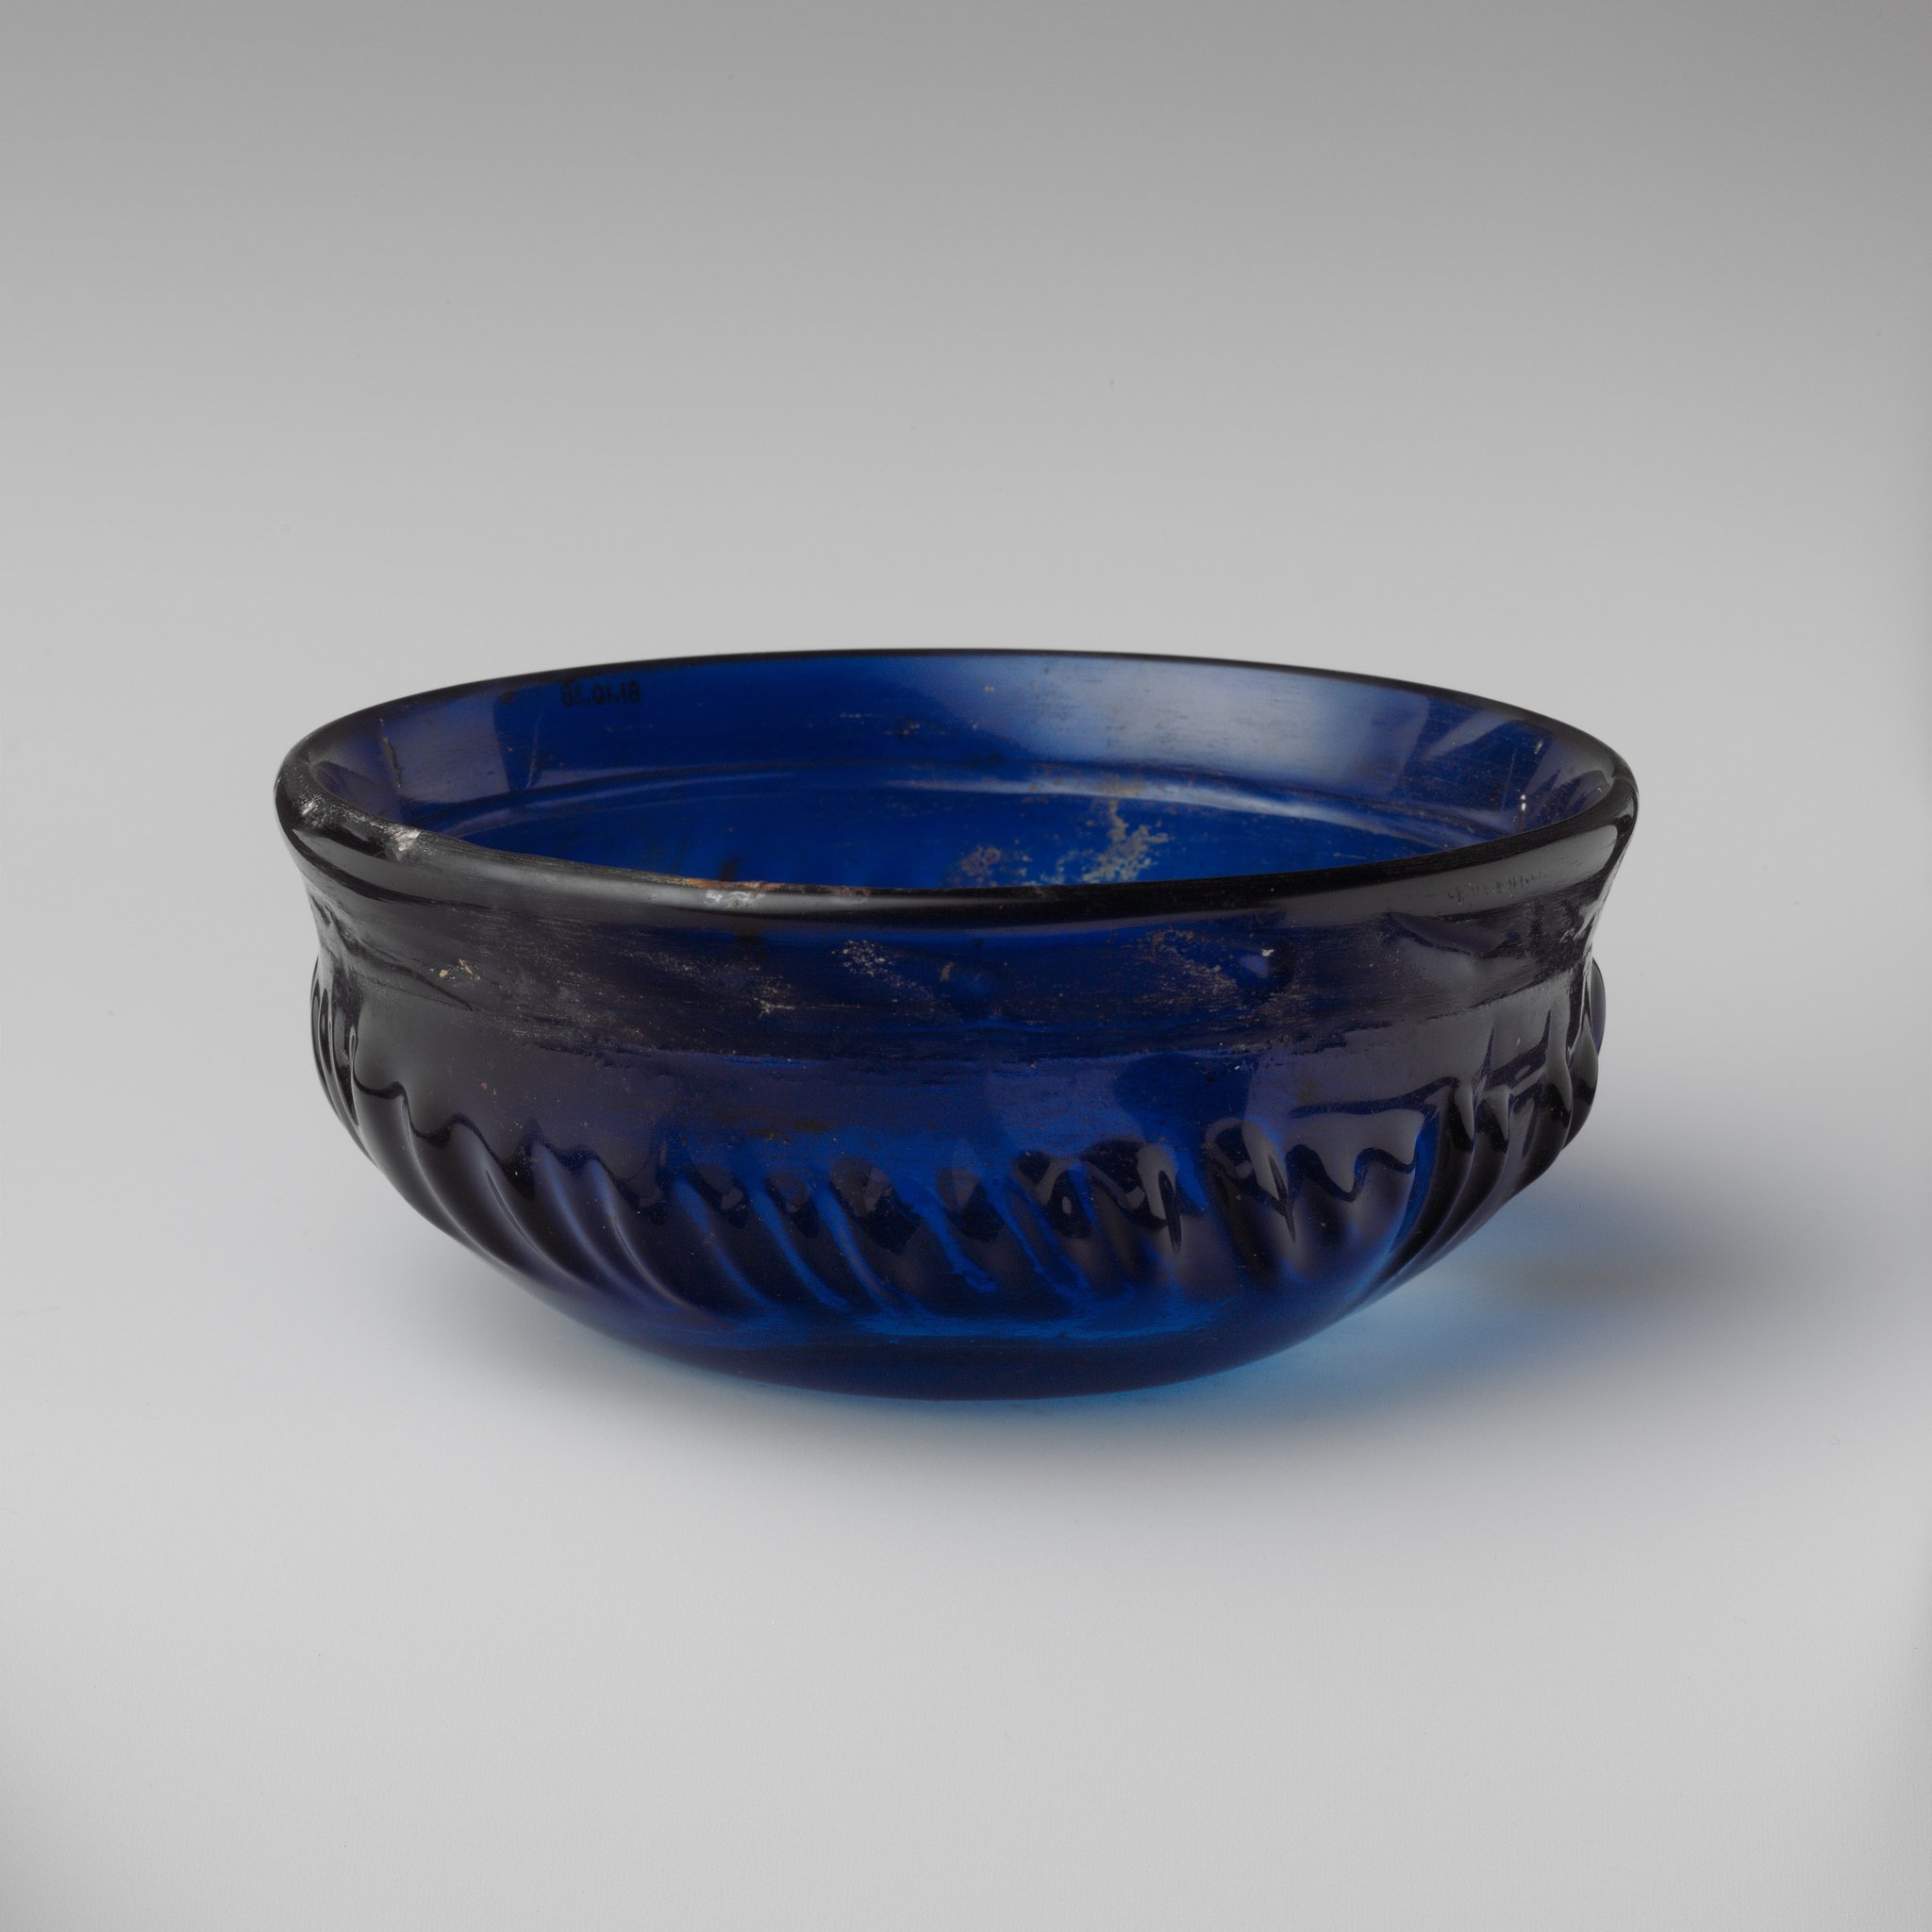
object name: bowl, ribbed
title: Glass ribbed bowl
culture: roman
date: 1-50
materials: glass